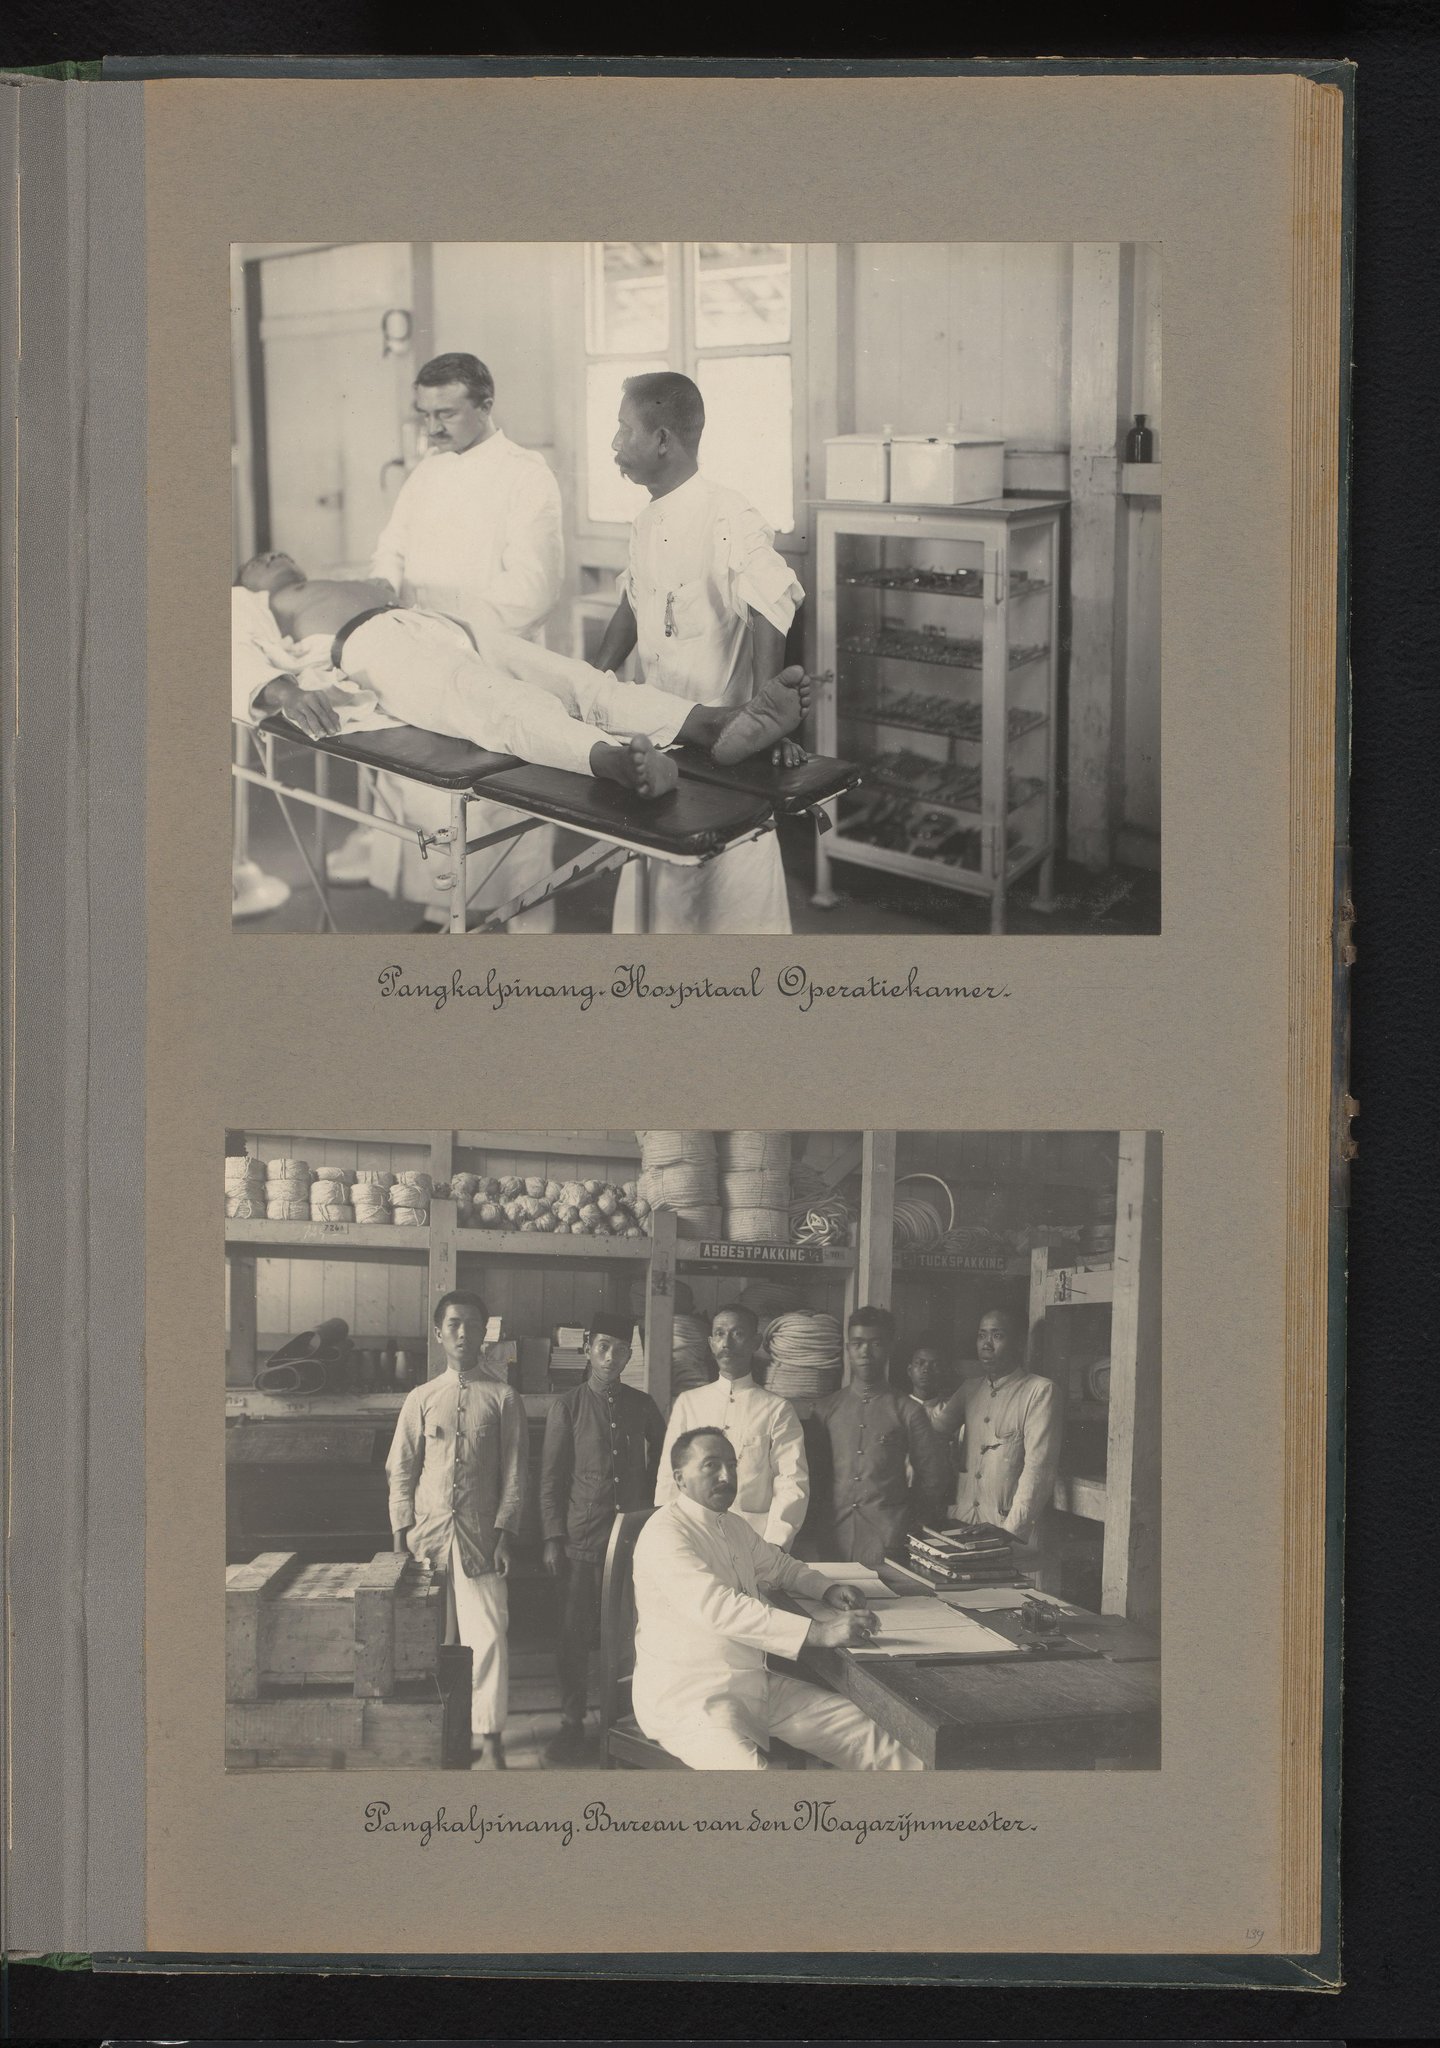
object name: photograph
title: Personeel van het hospitaal en magazijn te Pangkalpinang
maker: Anonymous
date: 1914-1919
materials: cardboard, photographic support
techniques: gelatin silver print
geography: bangka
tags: robert julius boers, colonial system, mining, operating room, office (~ administration)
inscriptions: inscription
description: Albumblad met 2 foto's van het personeel van het hospitaal en magazijn van de mijnbouwonderneming te Pangkalpinang. Onderdeel van het fotoalbum aangeboden aan Robert Julius Boers bij zijn vertrek naar Nederland in 1919 door het personeel van de Banka-tinwinning.